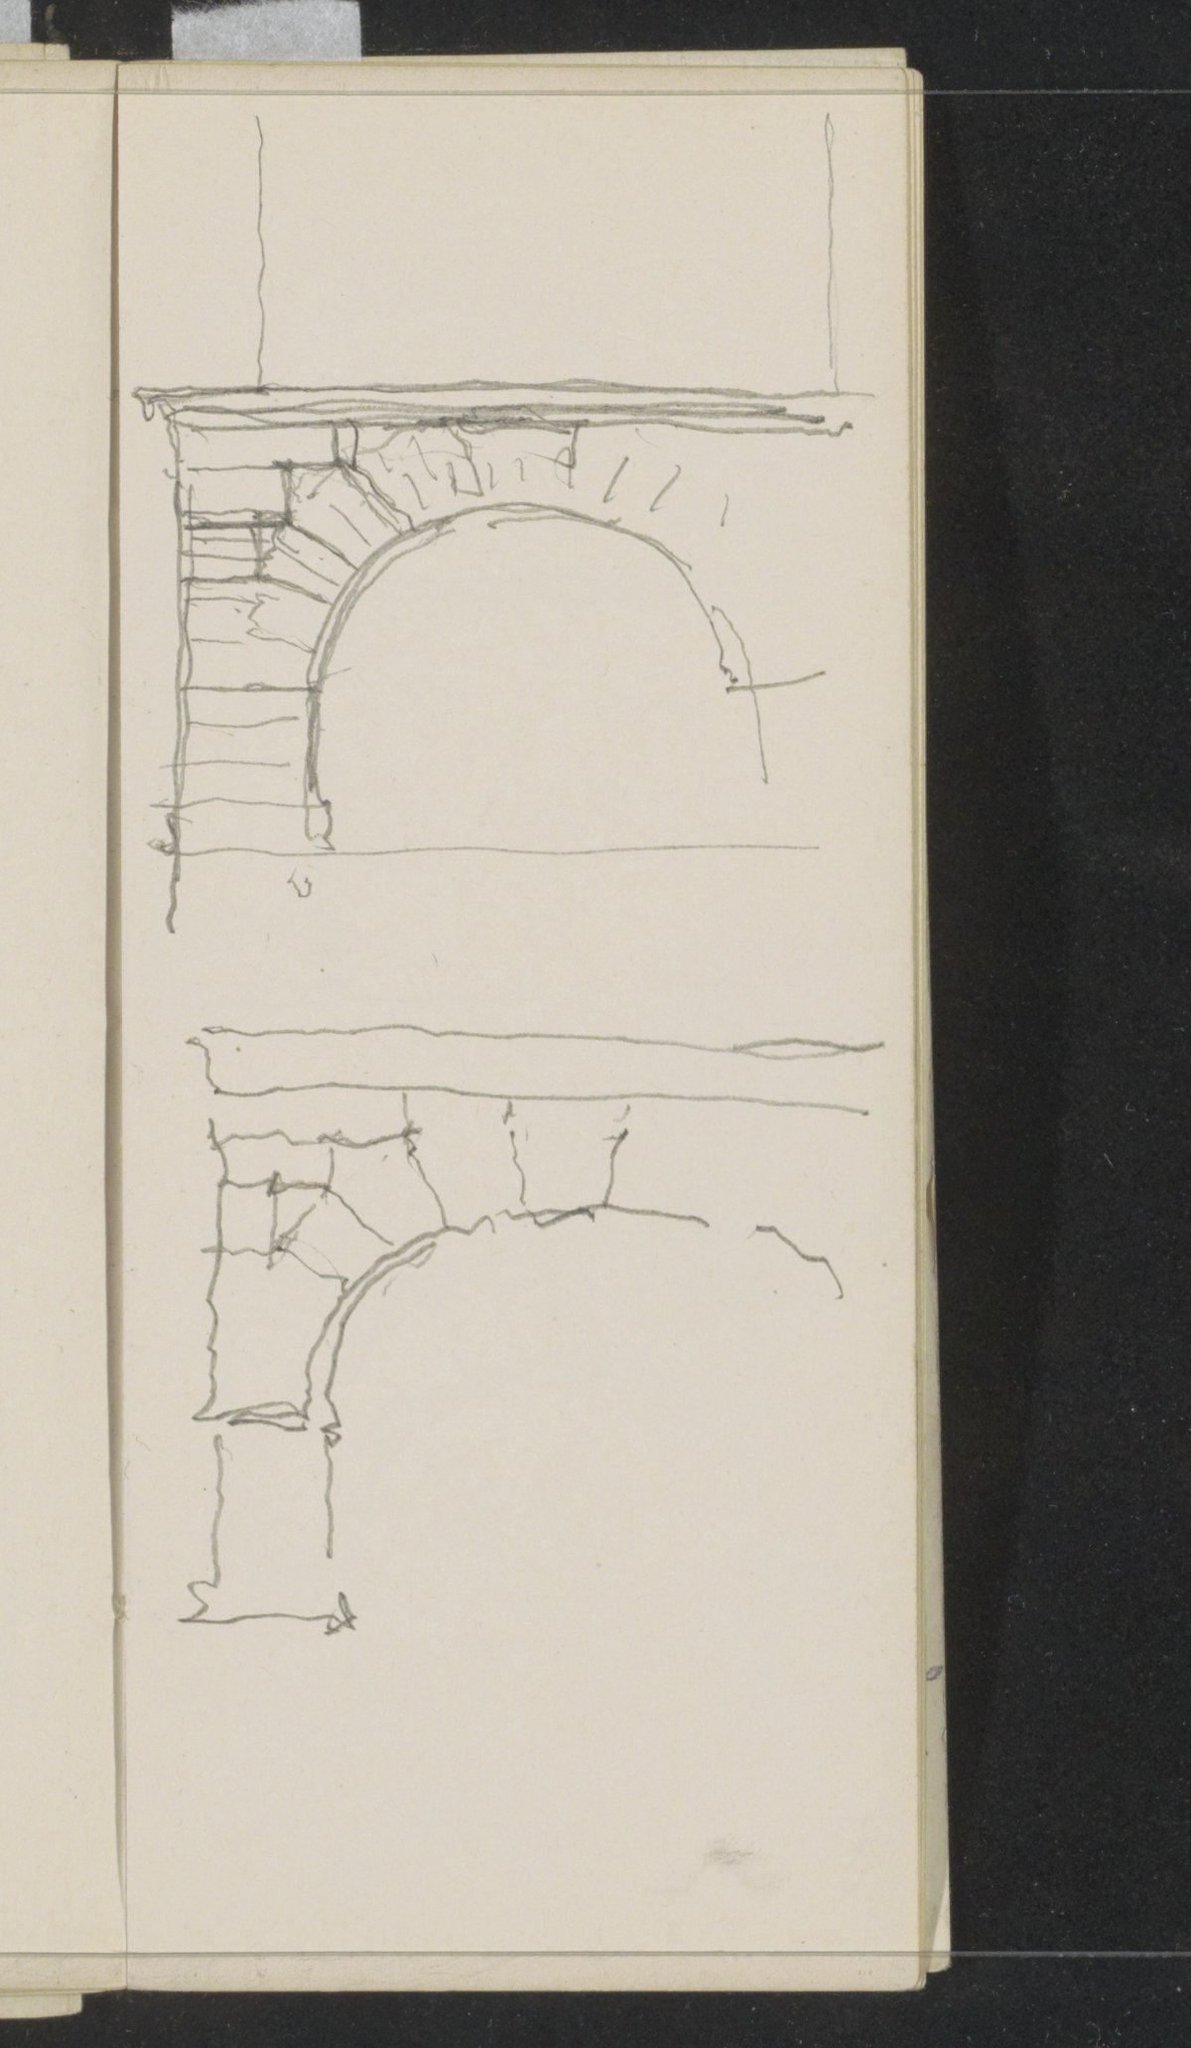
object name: sketchbook leaf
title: Twee stenen bogen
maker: gerrit willem dijsselhof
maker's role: designer, draughtsman, print maker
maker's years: 1866-1924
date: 1876-1924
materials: paper, pencil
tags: arch, archivolt ~ architecture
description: Blad 20 recto uit een schetsboek met 24 bladen.